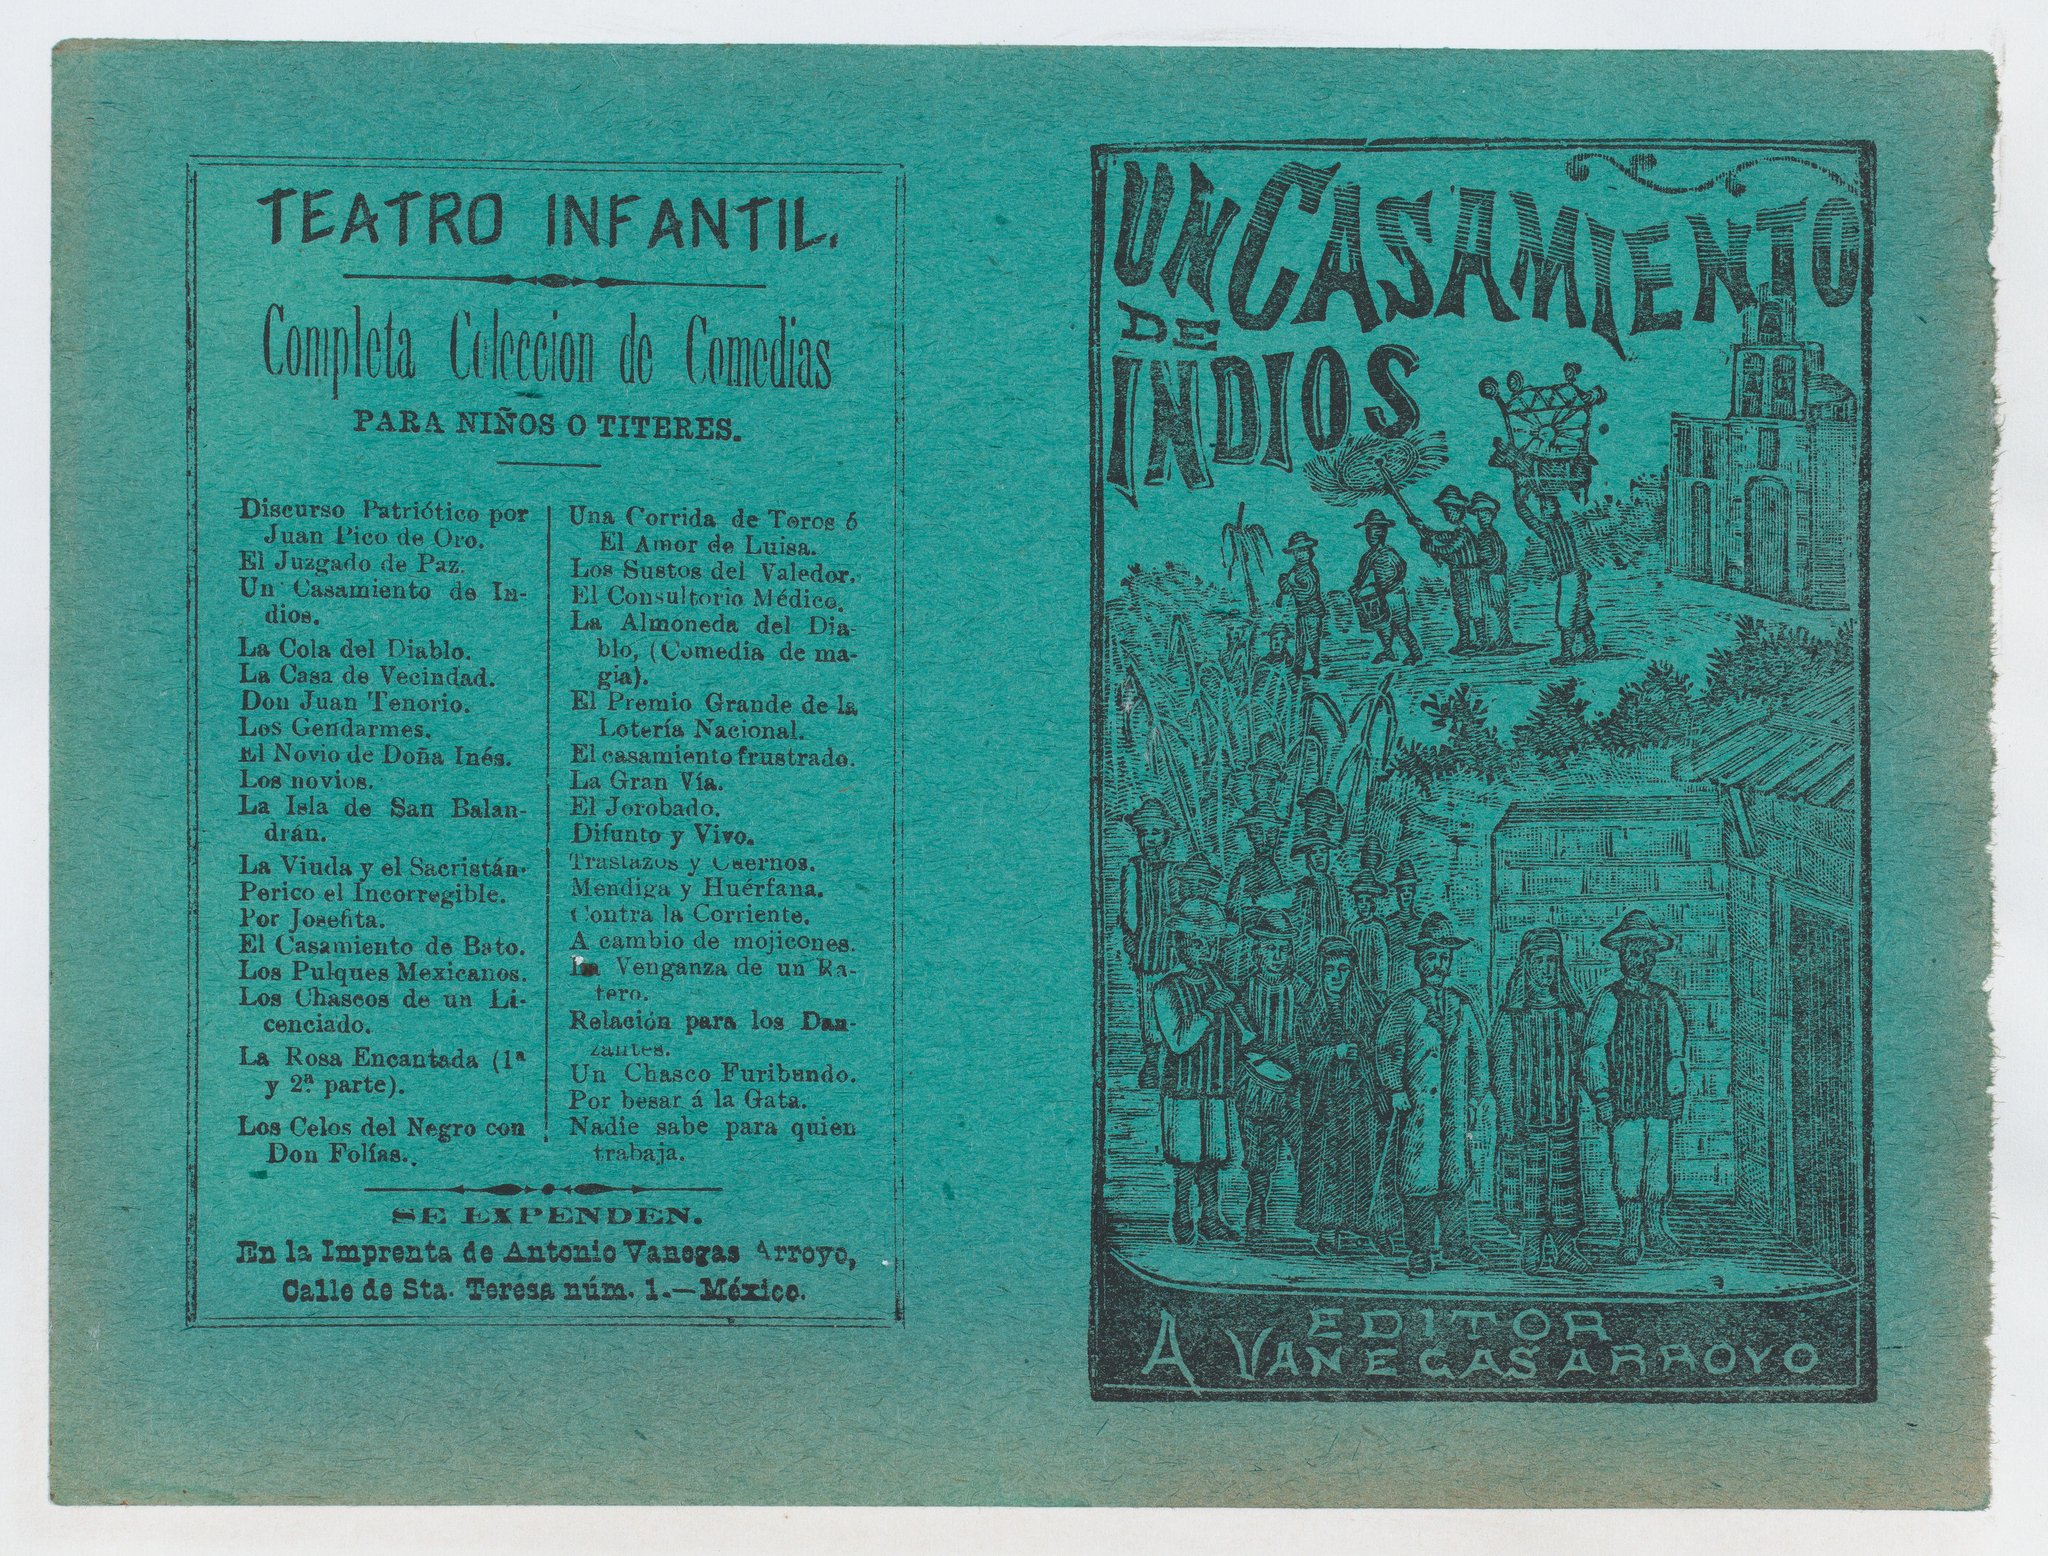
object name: print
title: Cover for 'Un Casamiento de Indios', a wedding procession following a bride and groom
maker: josé guadalupe posada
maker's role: artist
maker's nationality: mexican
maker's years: 1852-1913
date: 1890-1910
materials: metal, paper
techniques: engraving, letterpress, printing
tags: men,women,weddings,processions